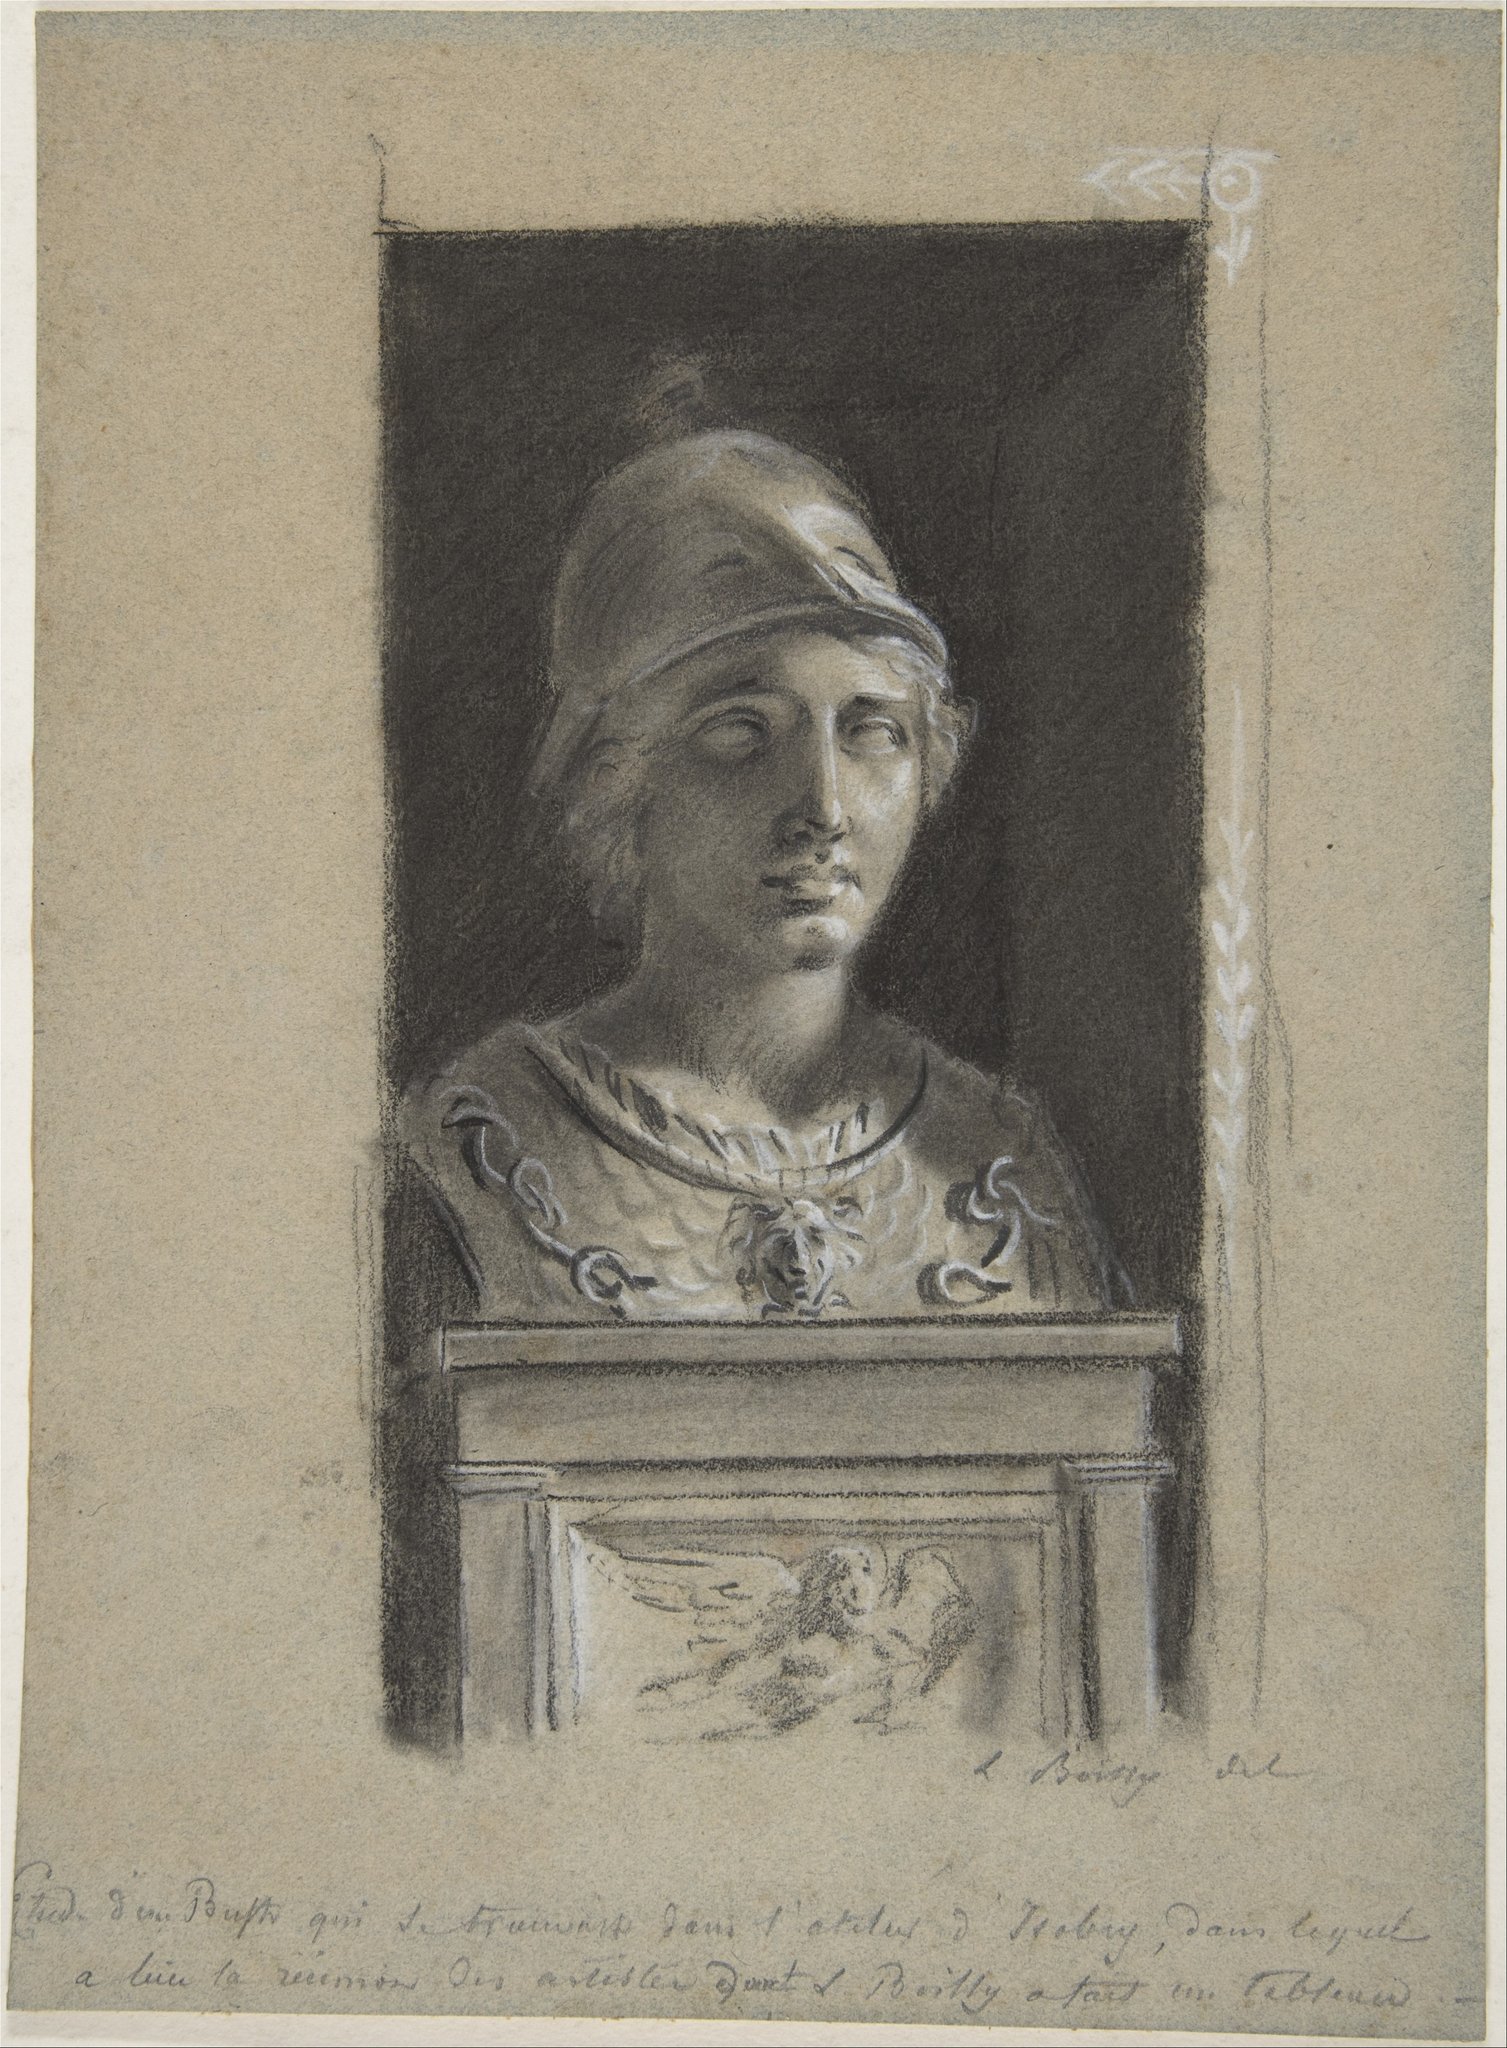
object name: drawing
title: Bust of Minerva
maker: louis léopold boilly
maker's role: artist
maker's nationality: french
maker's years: 1761-1845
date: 1798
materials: chalk, crayon, paper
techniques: heightening, stumping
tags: minerva